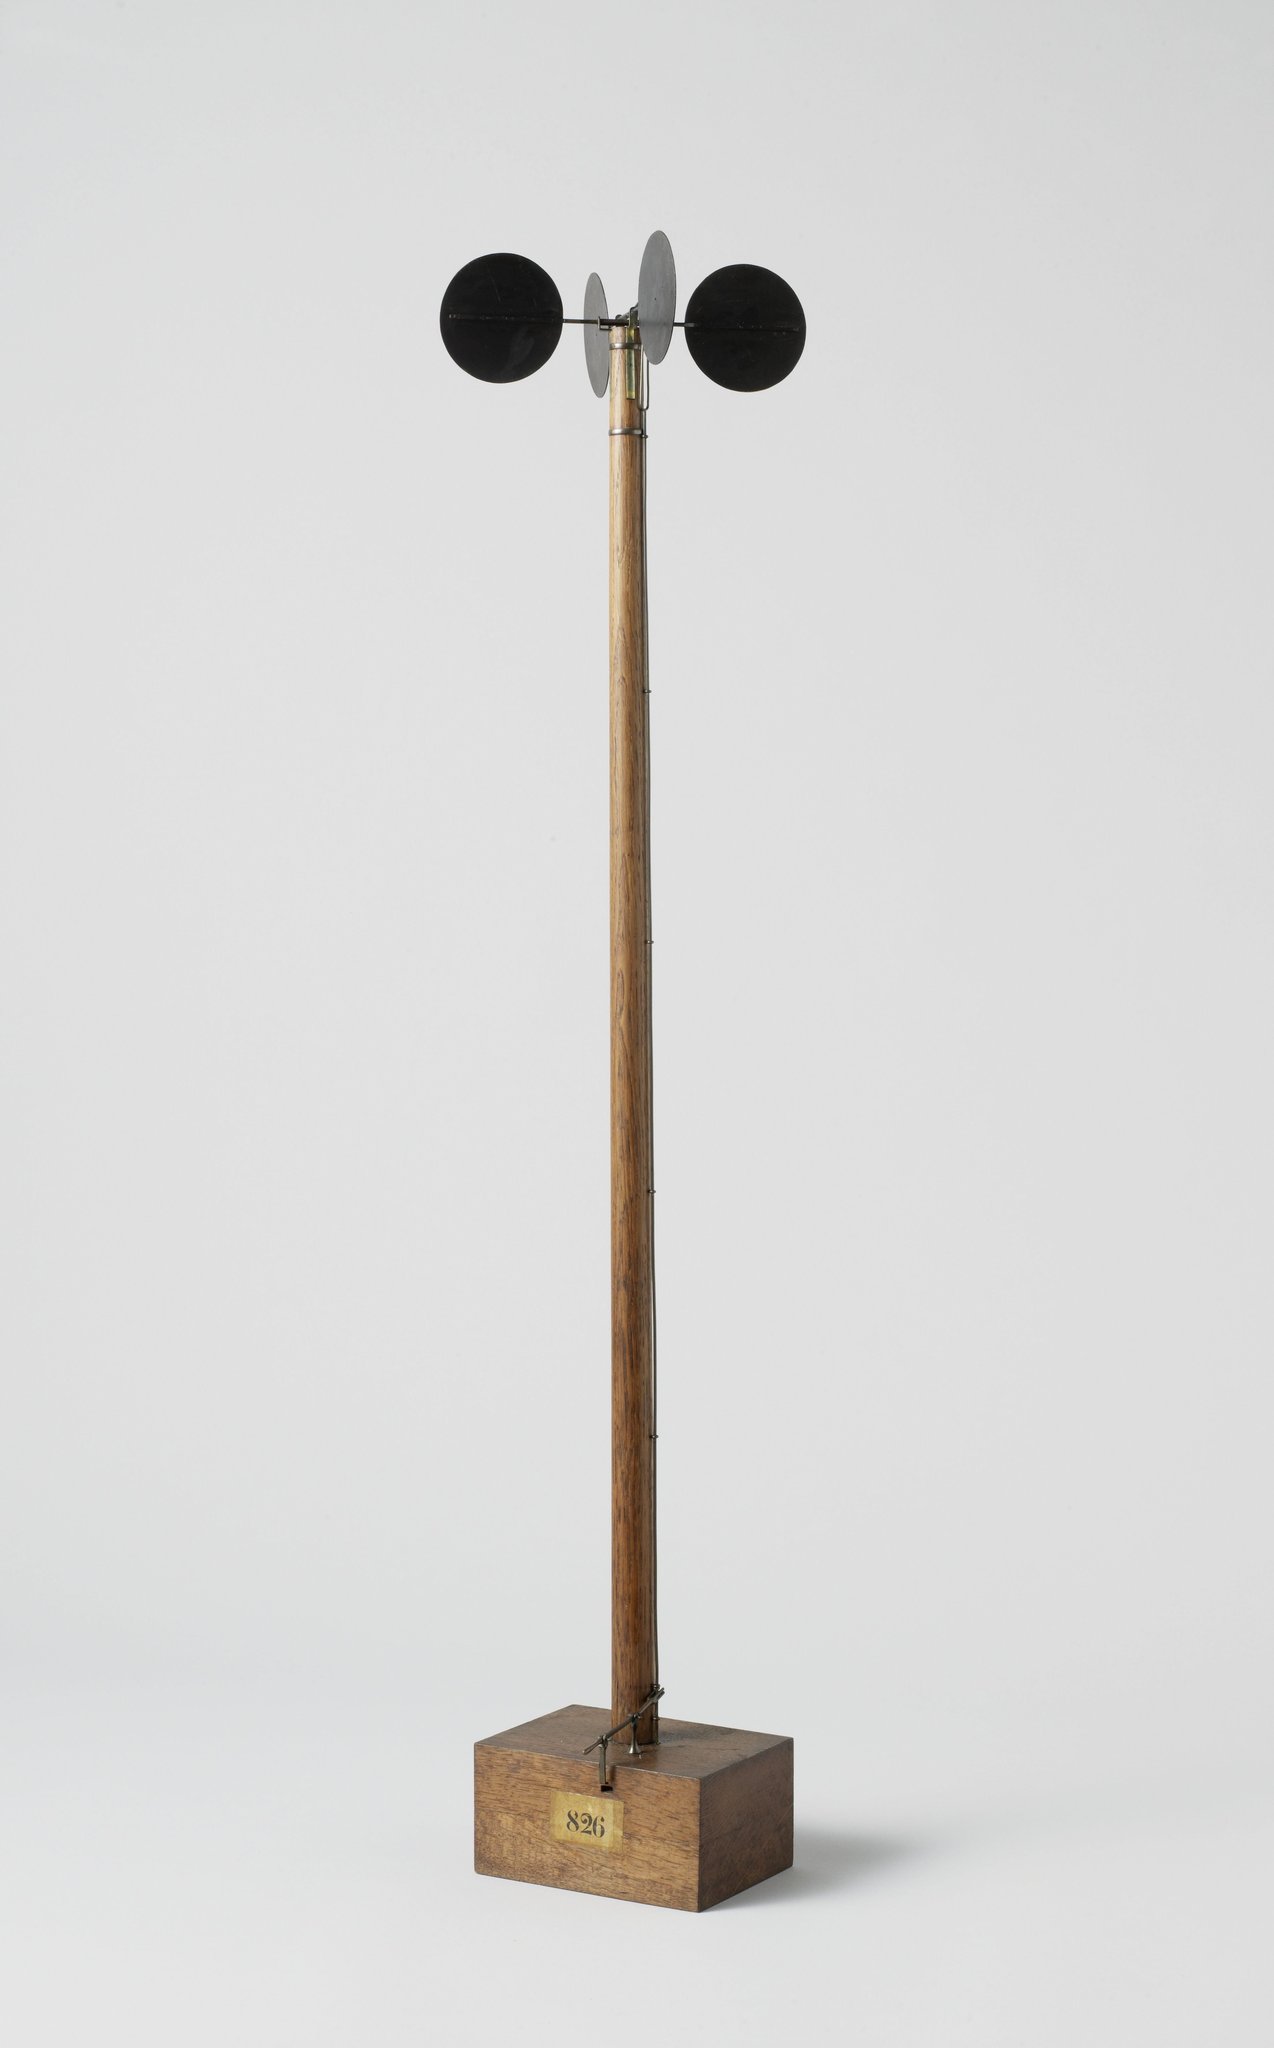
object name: demonstration model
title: Model of a Time Signal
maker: petrus van der loo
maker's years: 1806-1864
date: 1849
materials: brass, wood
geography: the hague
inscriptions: label, on the base: ‘826’ former inventory label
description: Dit model werd door P. van der Loo gemaakt naar een origineel model door F. Kaiser naar Den Haag gezonden in 1849. Een kopie van dit model werd naar Batavia gestuurd, waar het eerste tijdsein van dit type in 1850 werd opgericht. Prof. F. Kaiser stelde dit type tijdsein voor het gelijk zetten van de chronometers aan boord van de schepen in 1846 voor, ter vervanging van de duurdere tijdballen en ze werden in de Nederlandse havens in de jaren 1850-1860 ingevoerd.